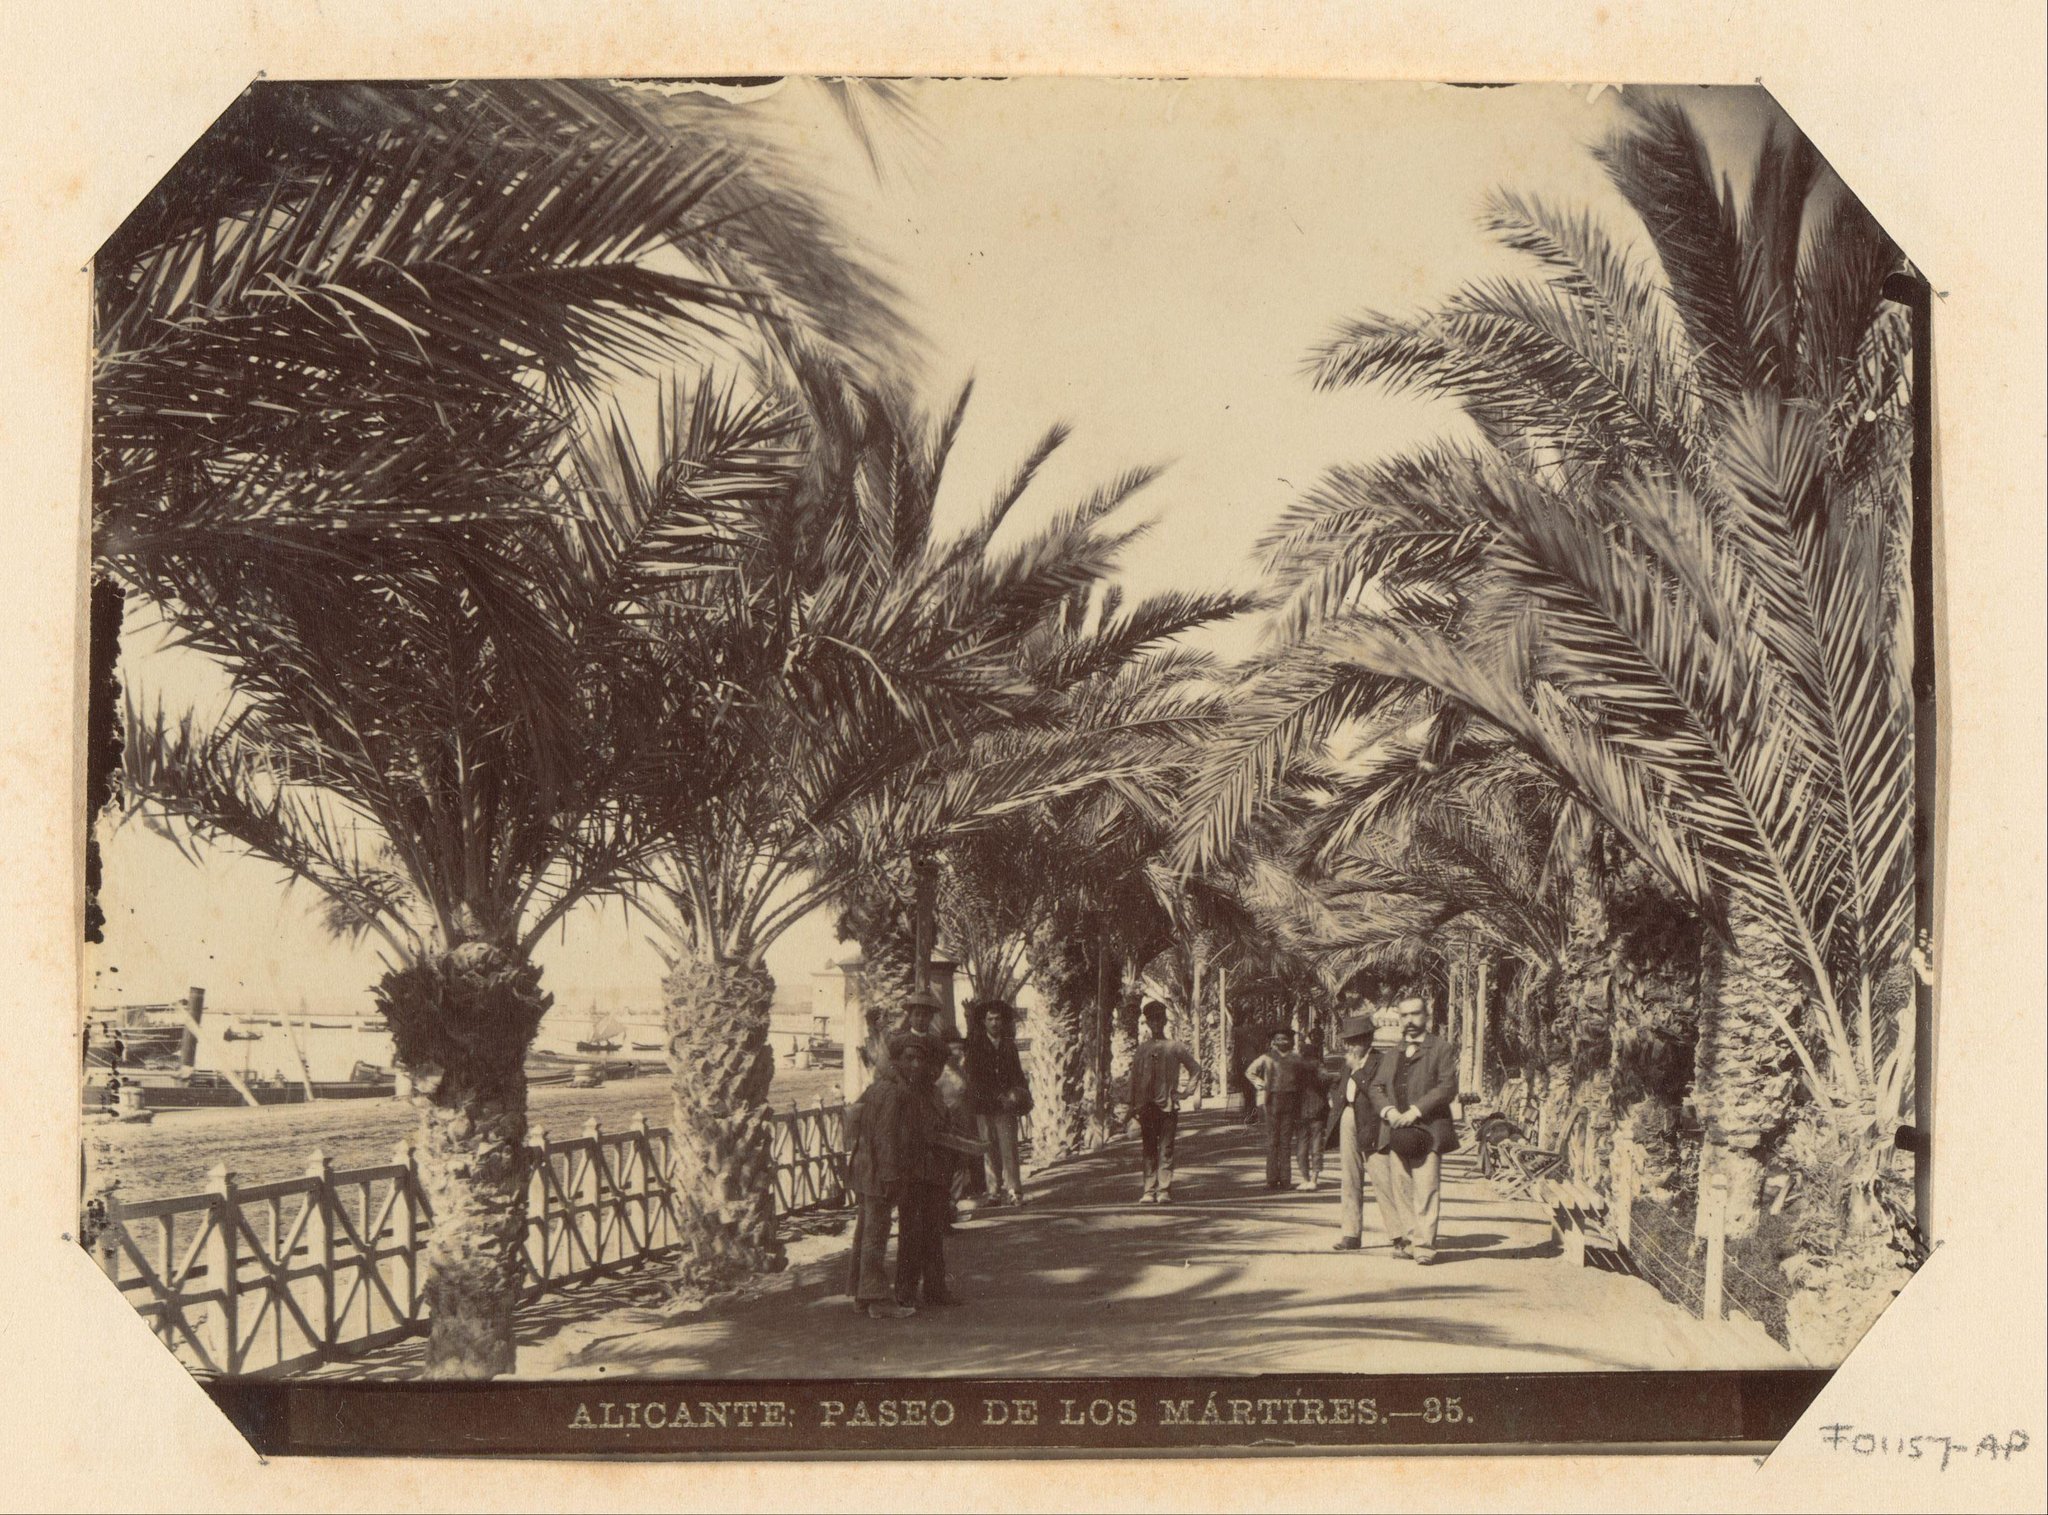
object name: album leaf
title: Straatgezicht van Paseo de los Mártires de la Libertad te Alicante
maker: Anonymous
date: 1885-1892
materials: photographic support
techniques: albumen print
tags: trees: palm-tree, street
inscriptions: number: ‘35.’, annotation: ‘Alicante - Paseo de los Martires’